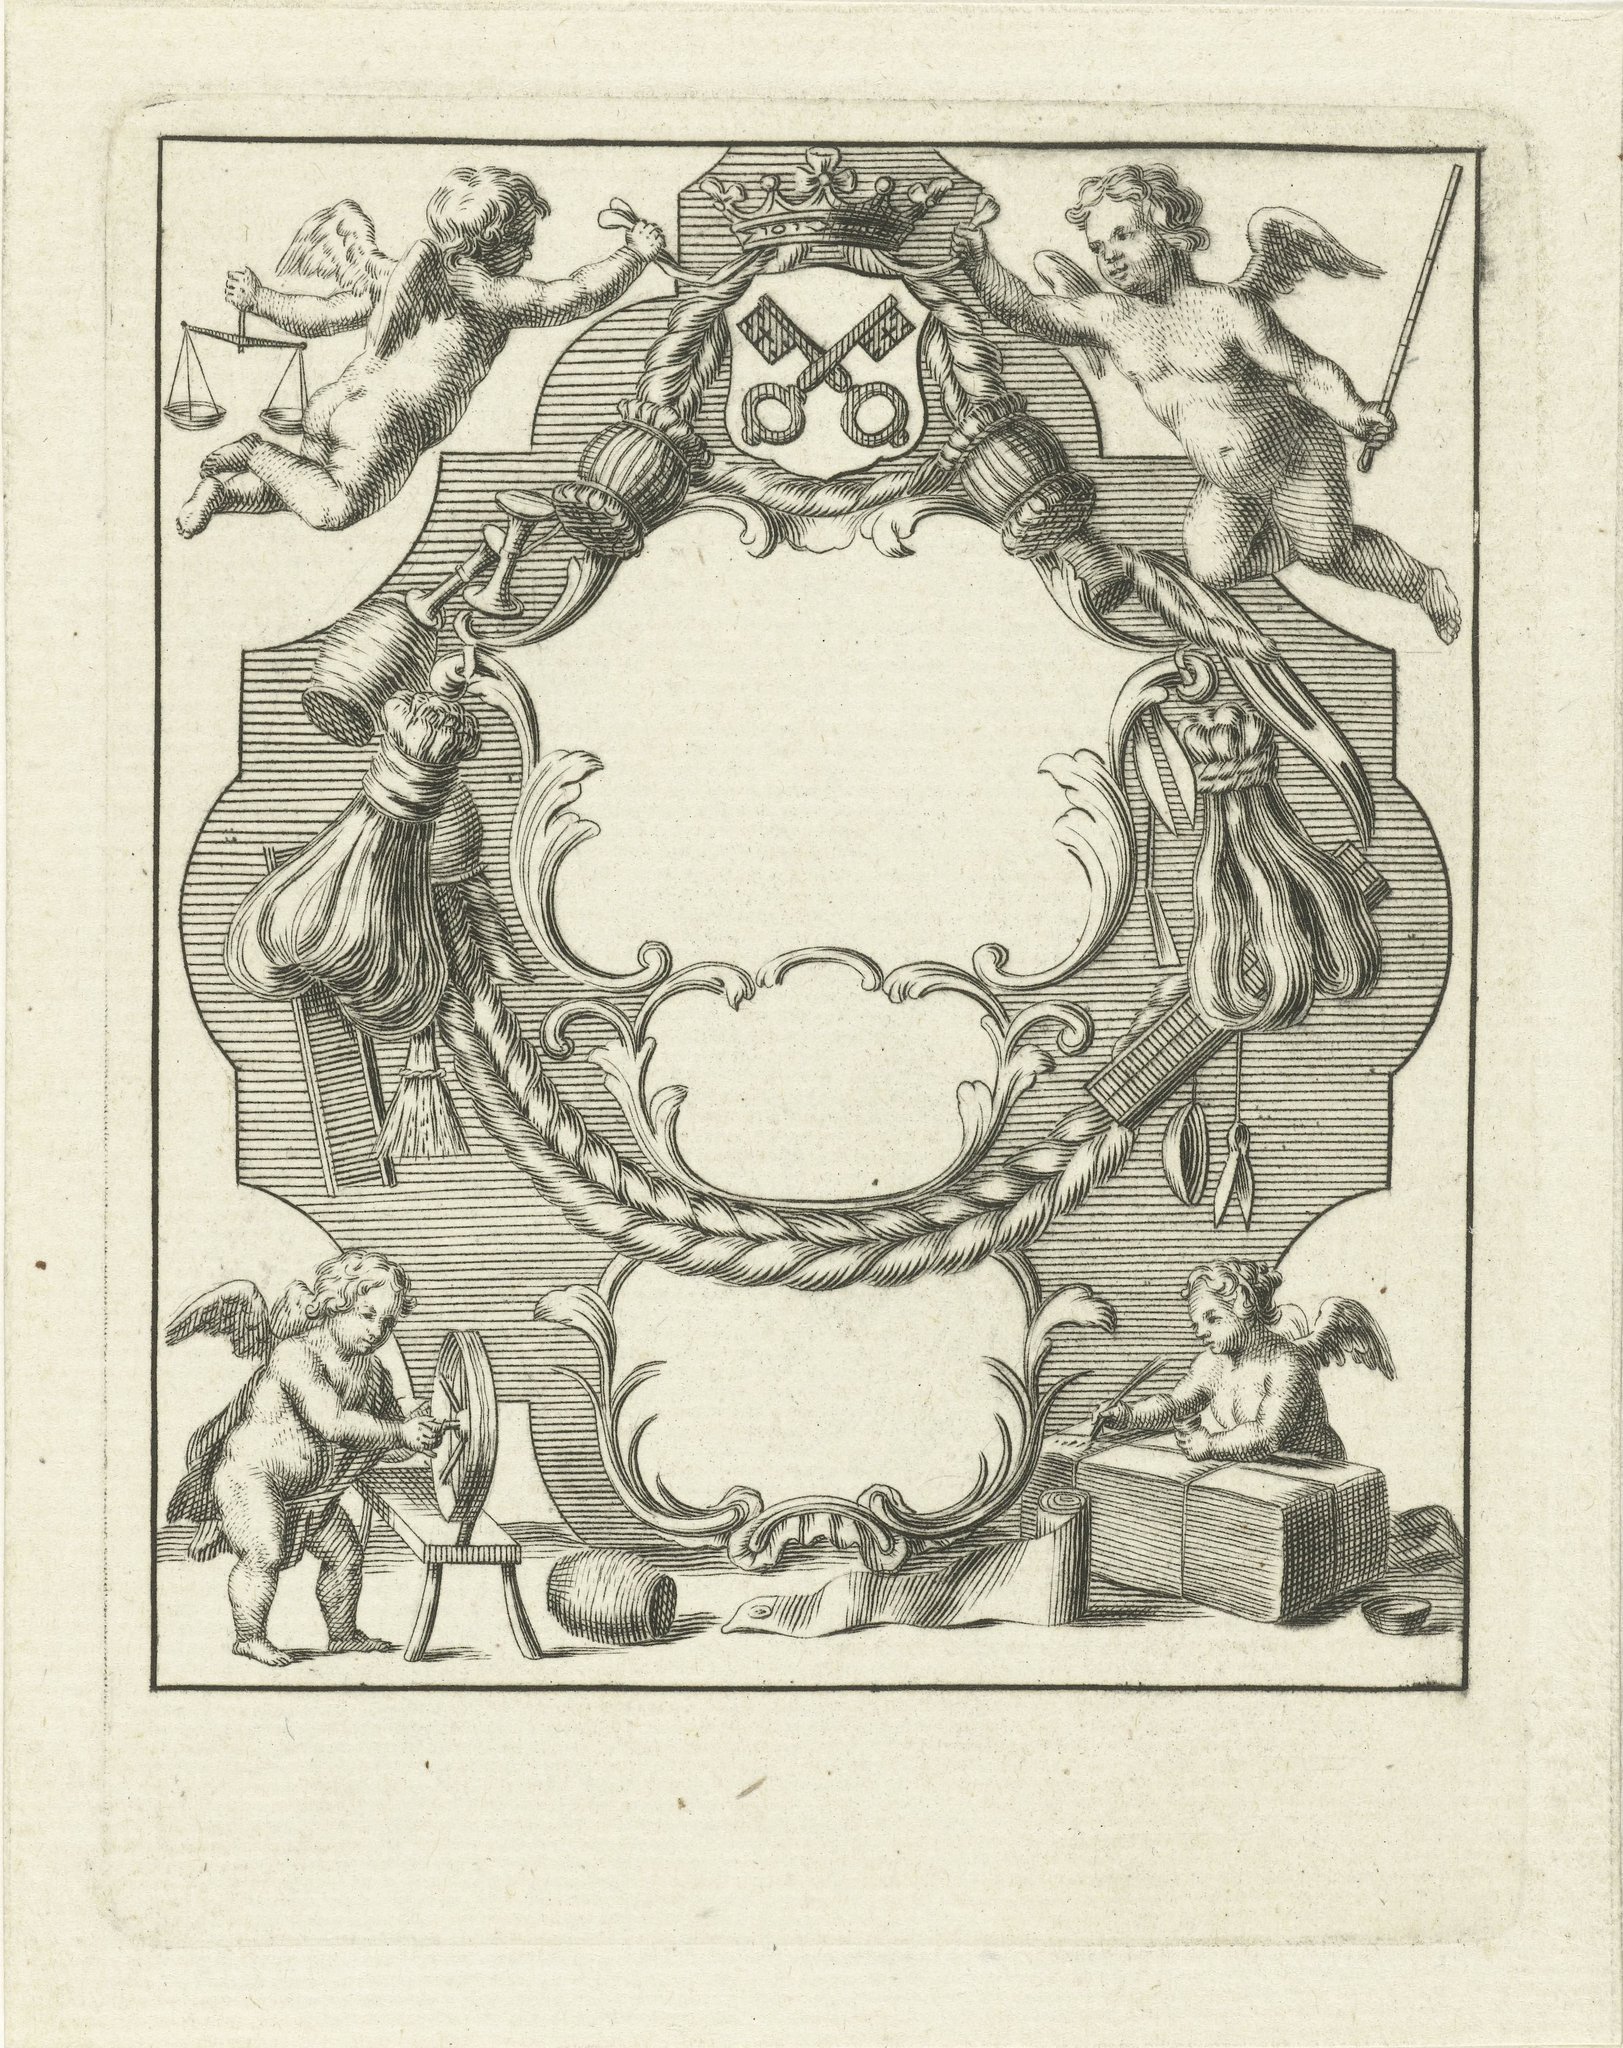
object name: print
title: Cartouche met kleine engelen en materialen uit wolindustrie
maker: abraham delfos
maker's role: draughtsman, painter, print maker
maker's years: 1731-1820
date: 1741-1820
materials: paper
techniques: etching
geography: leiden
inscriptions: collector's mark: Lugt 240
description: Cartouche met kleine engelen aan weerszijden van wapen van Leiden. Cartouche versierd met materialen en gereedschappen uit wolindustrie zoals strengen ruwe wol, klossen, kwasten en schaar van schapenscheerder. Onder spint een engeltje wol en een ander engeltje maakt verpakkingen klaar.